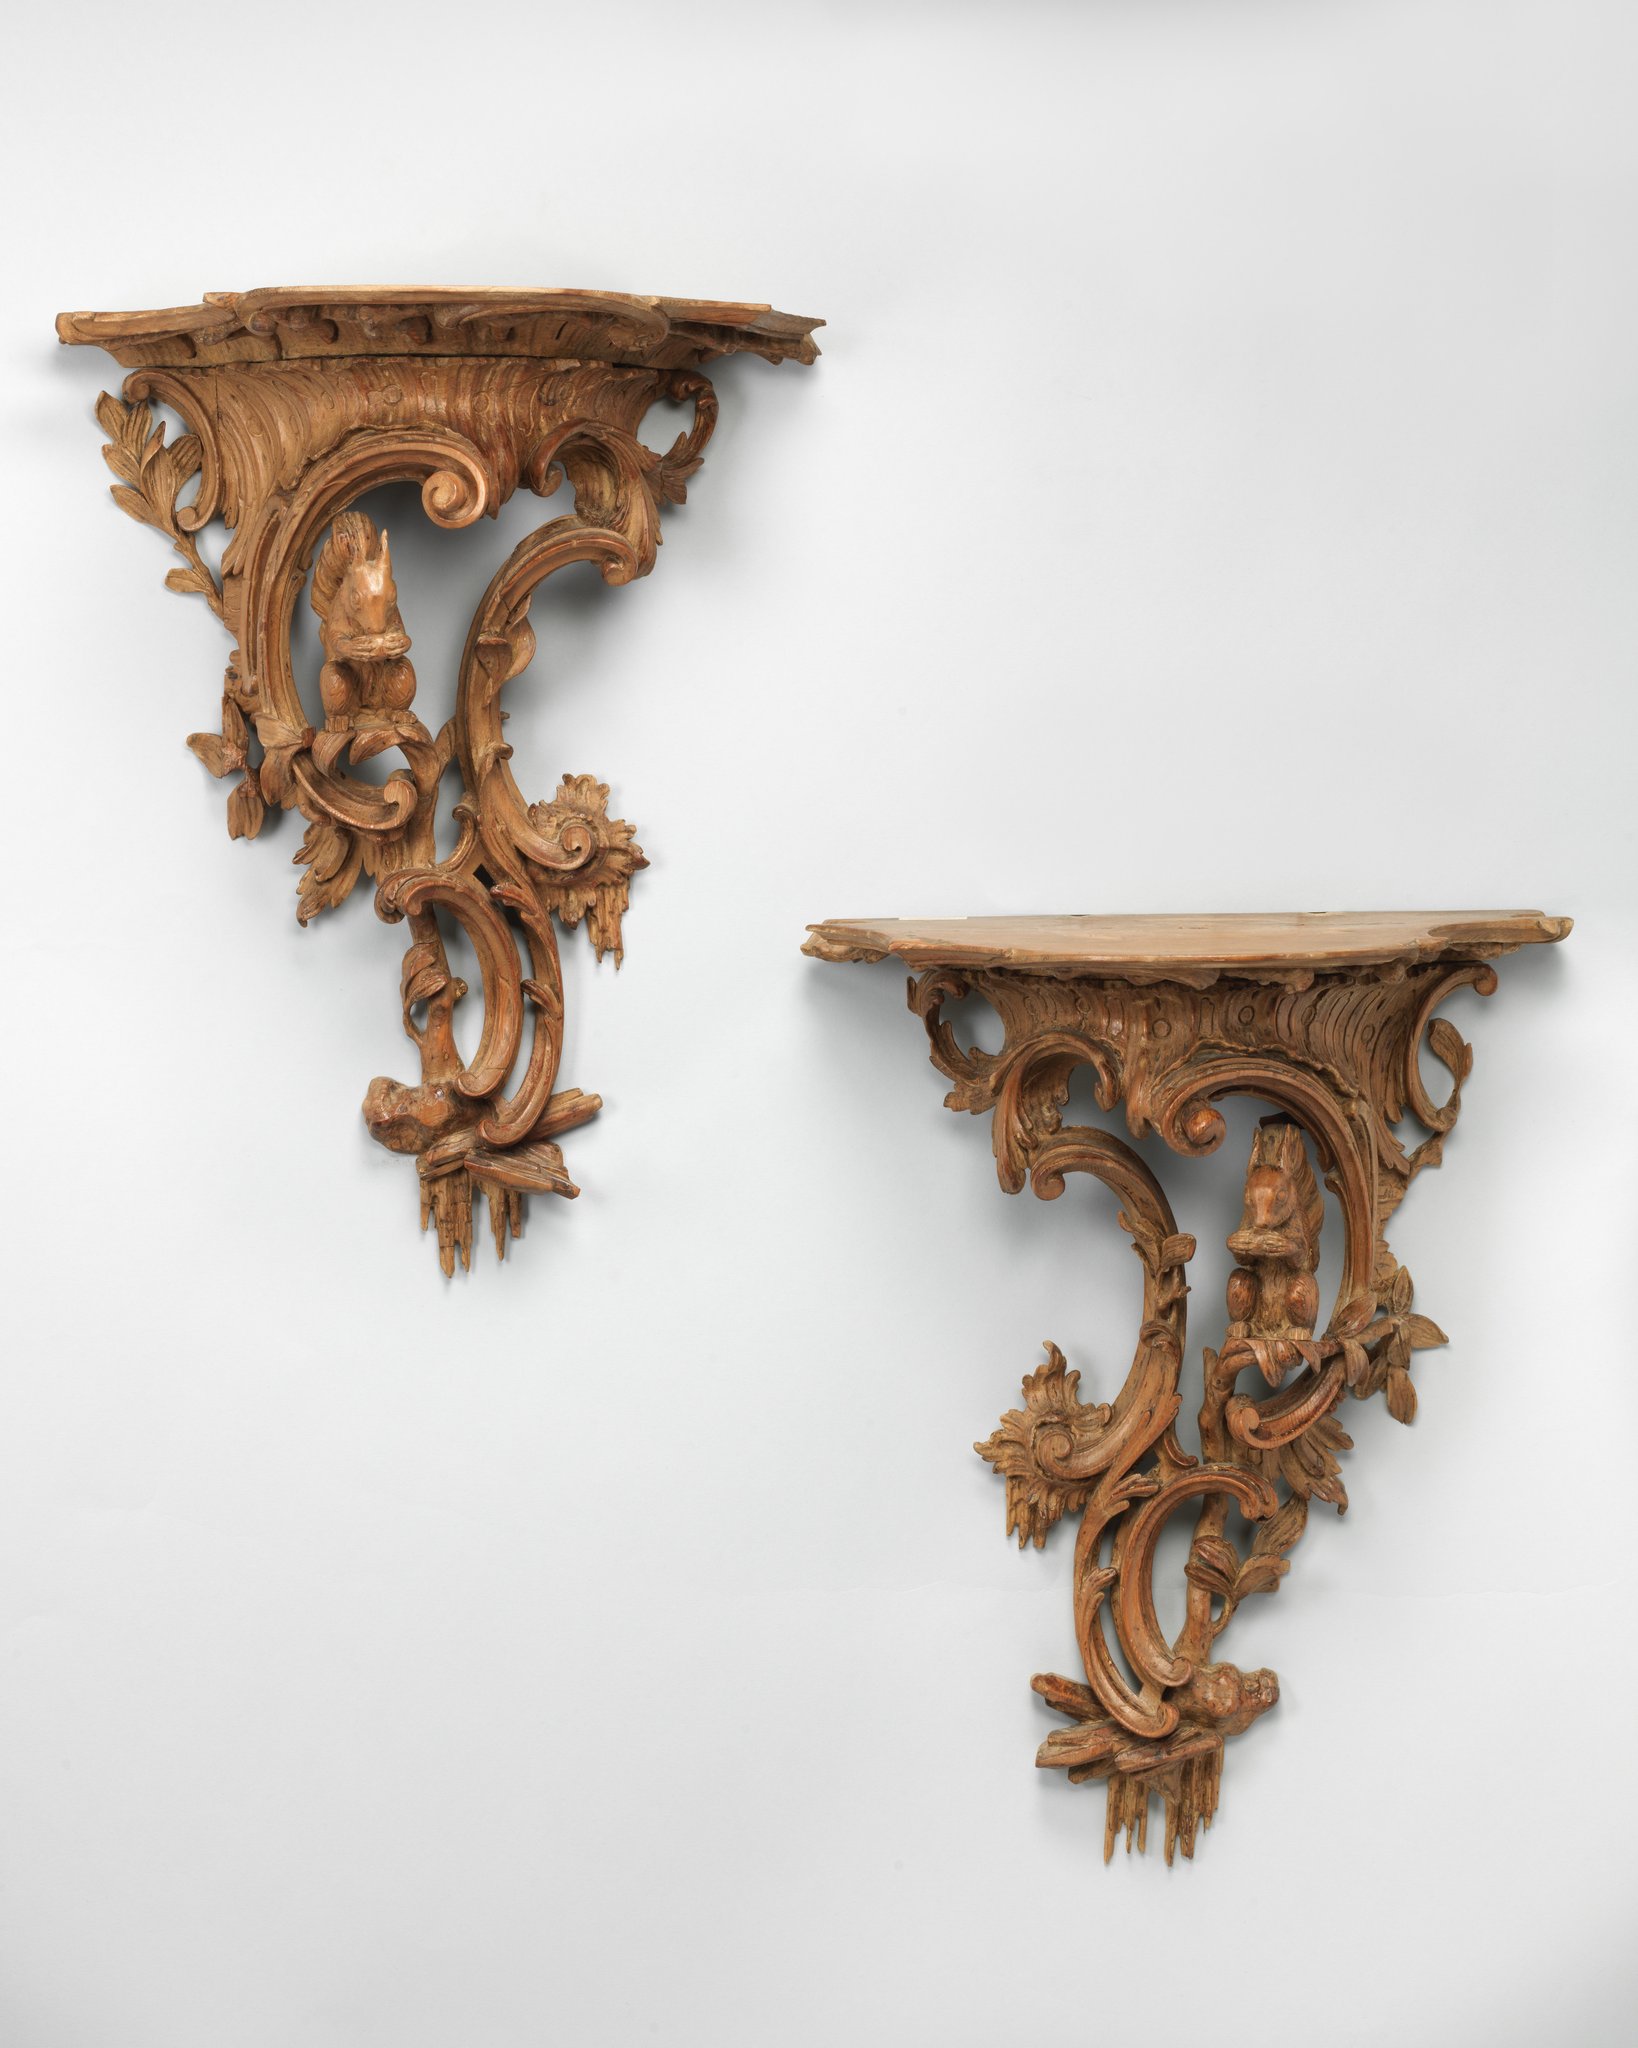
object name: bracket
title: Pair of brackets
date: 1760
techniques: stain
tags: squirrels